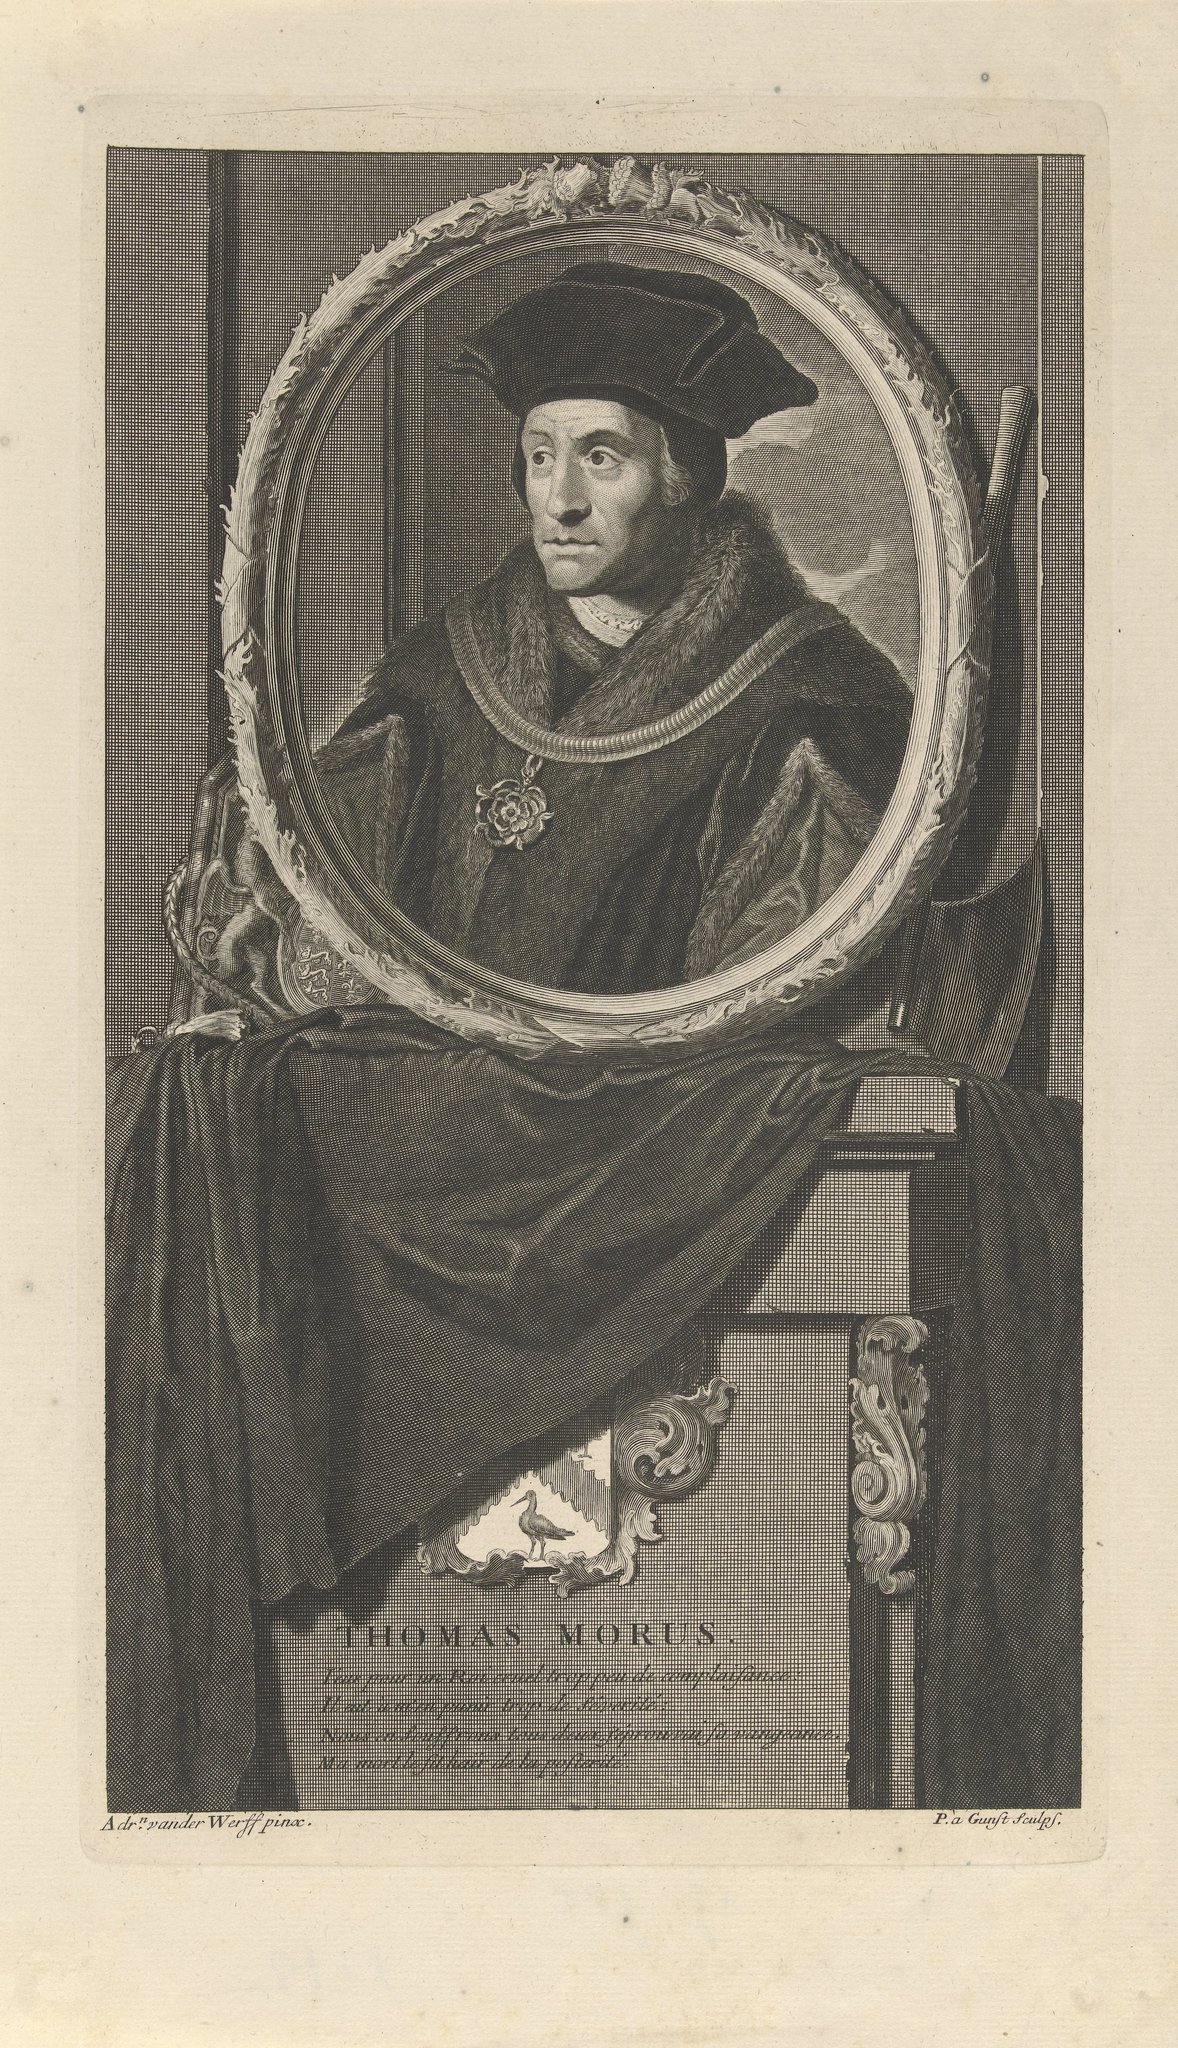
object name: print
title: Portret van Thomas More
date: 1669-1731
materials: paper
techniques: engraving, etching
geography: amsterdam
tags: london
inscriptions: collector's mark: Lugt 2228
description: Thomas More, humanist en Lord Chancellor van Engeland gedurende de vroege regeringsperiode van Hendrik VIII. Zijn wapenschild staat onder het portret. De prent heeft als onderschrift een Frans gedicht over zijn relatie met Hendrik VIII.